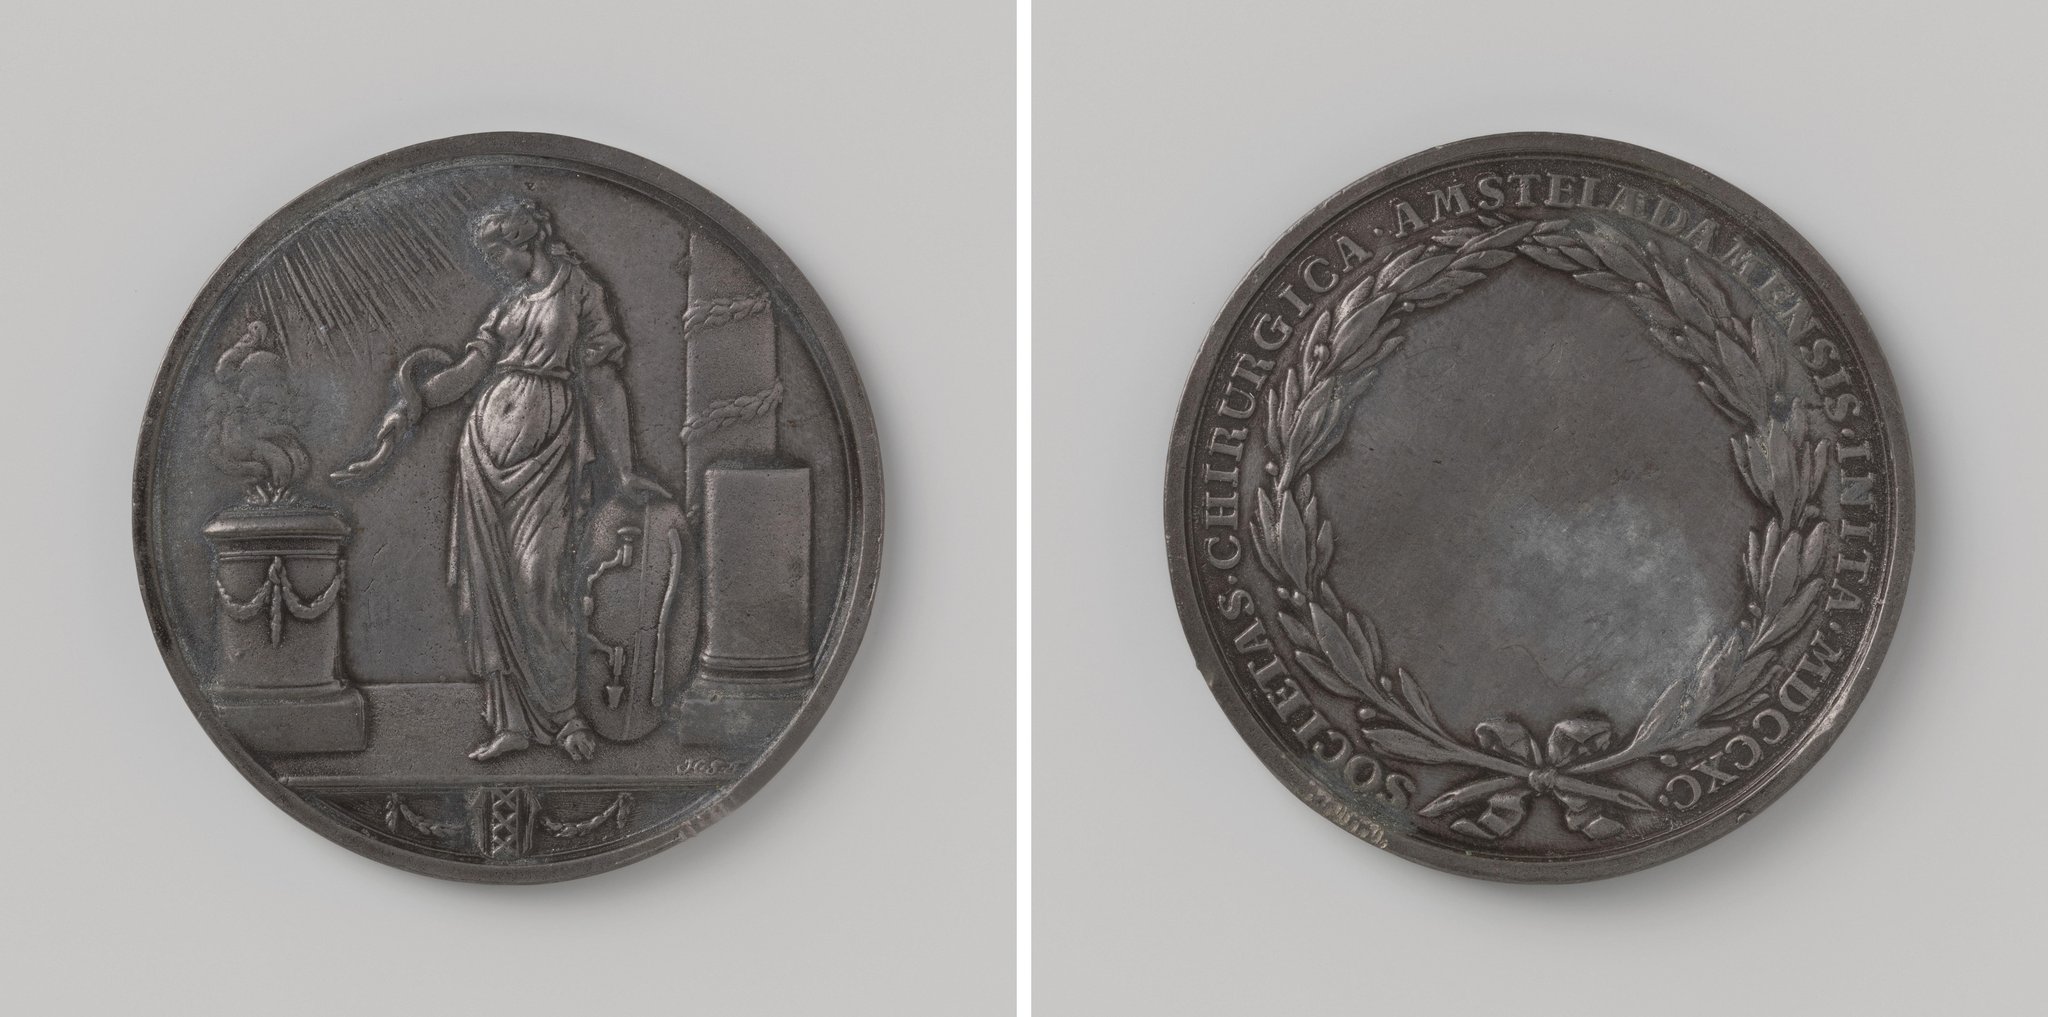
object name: medal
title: Genootschap tot Bevordering der heelkunde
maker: johann heinrich schepp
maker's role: sculptor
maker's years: 1736-1811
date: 1790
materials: lead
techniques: striking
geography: the hague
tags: amsterdam